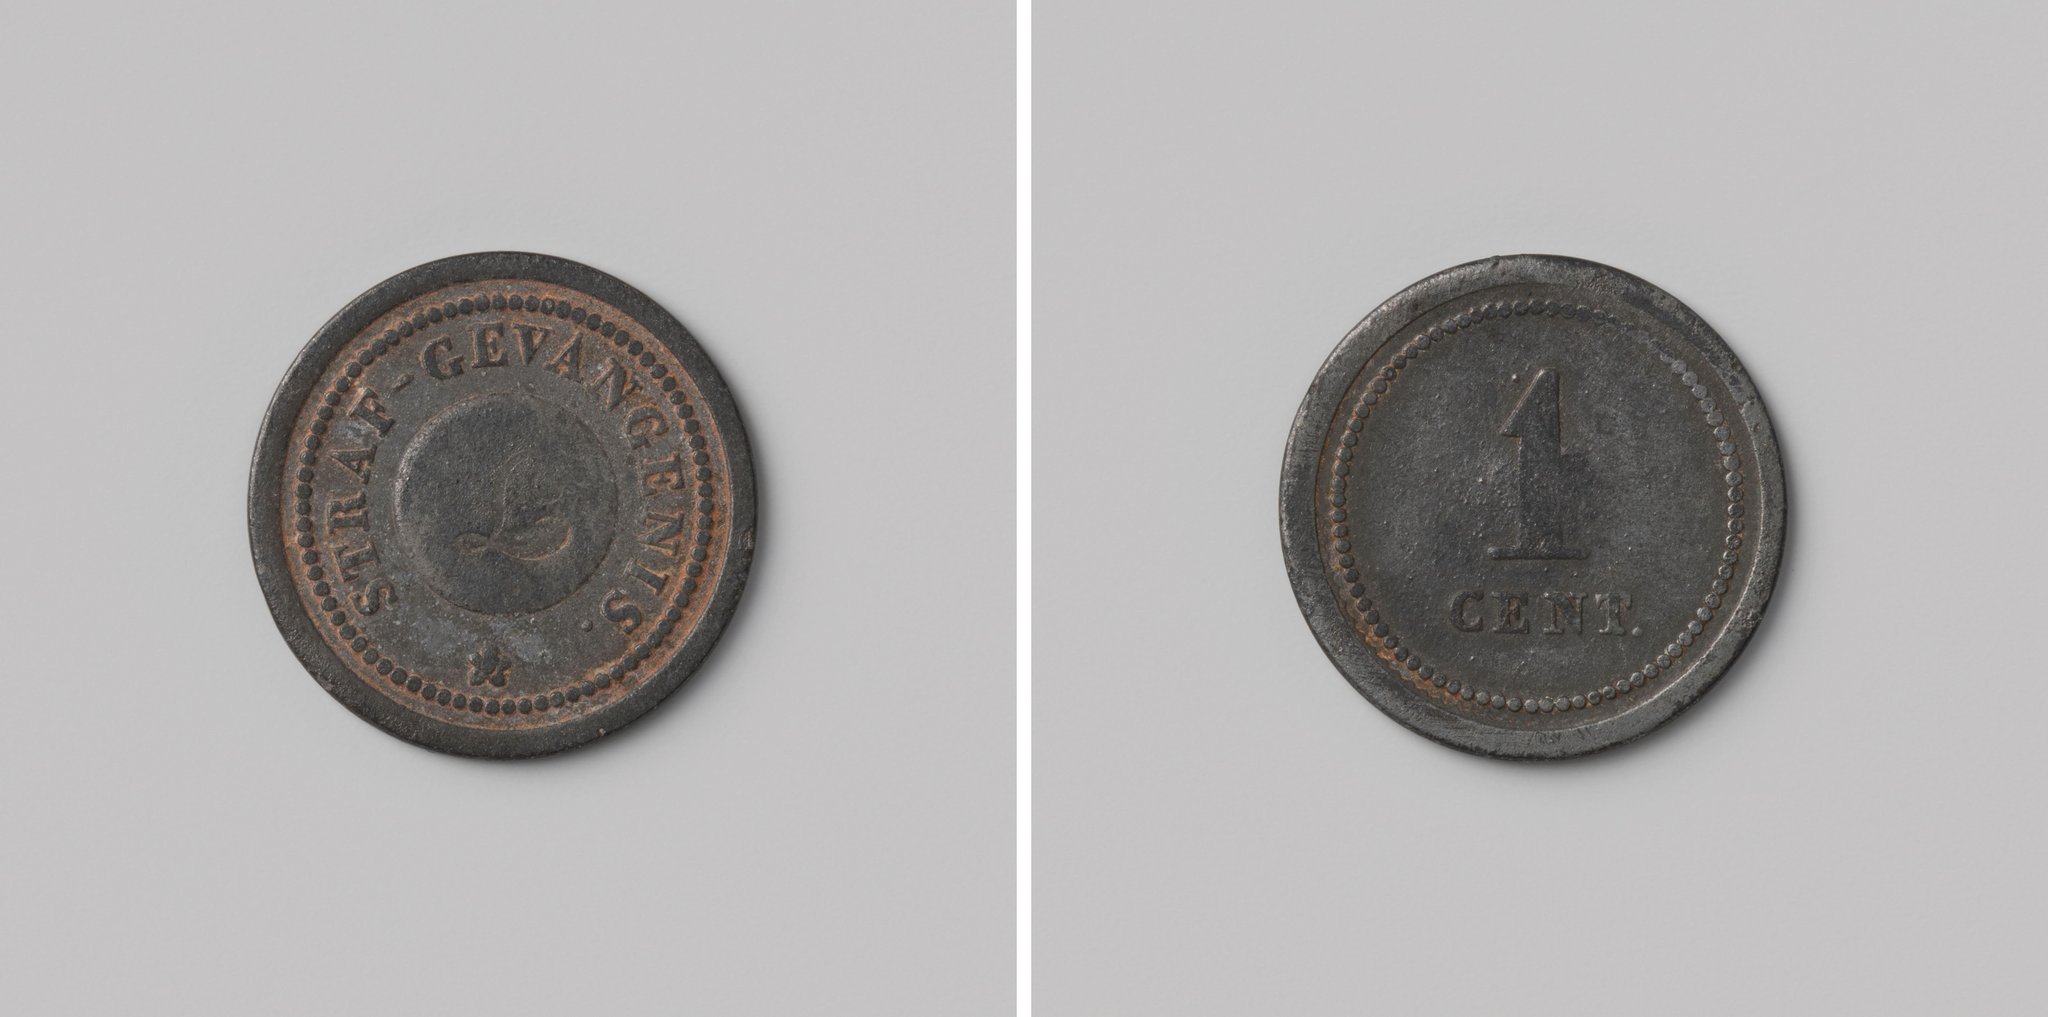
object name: cent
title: Strafgevangenis te Leeuwarden, huismunt ter waarde van 1 cent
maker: Anonymous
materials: zinc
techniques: striking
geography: utrecht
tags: leeuwarden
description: Zinken betaalpenning. Voorzijde: letter L binnen omschrift. Keerzijde: waardeaanduiding